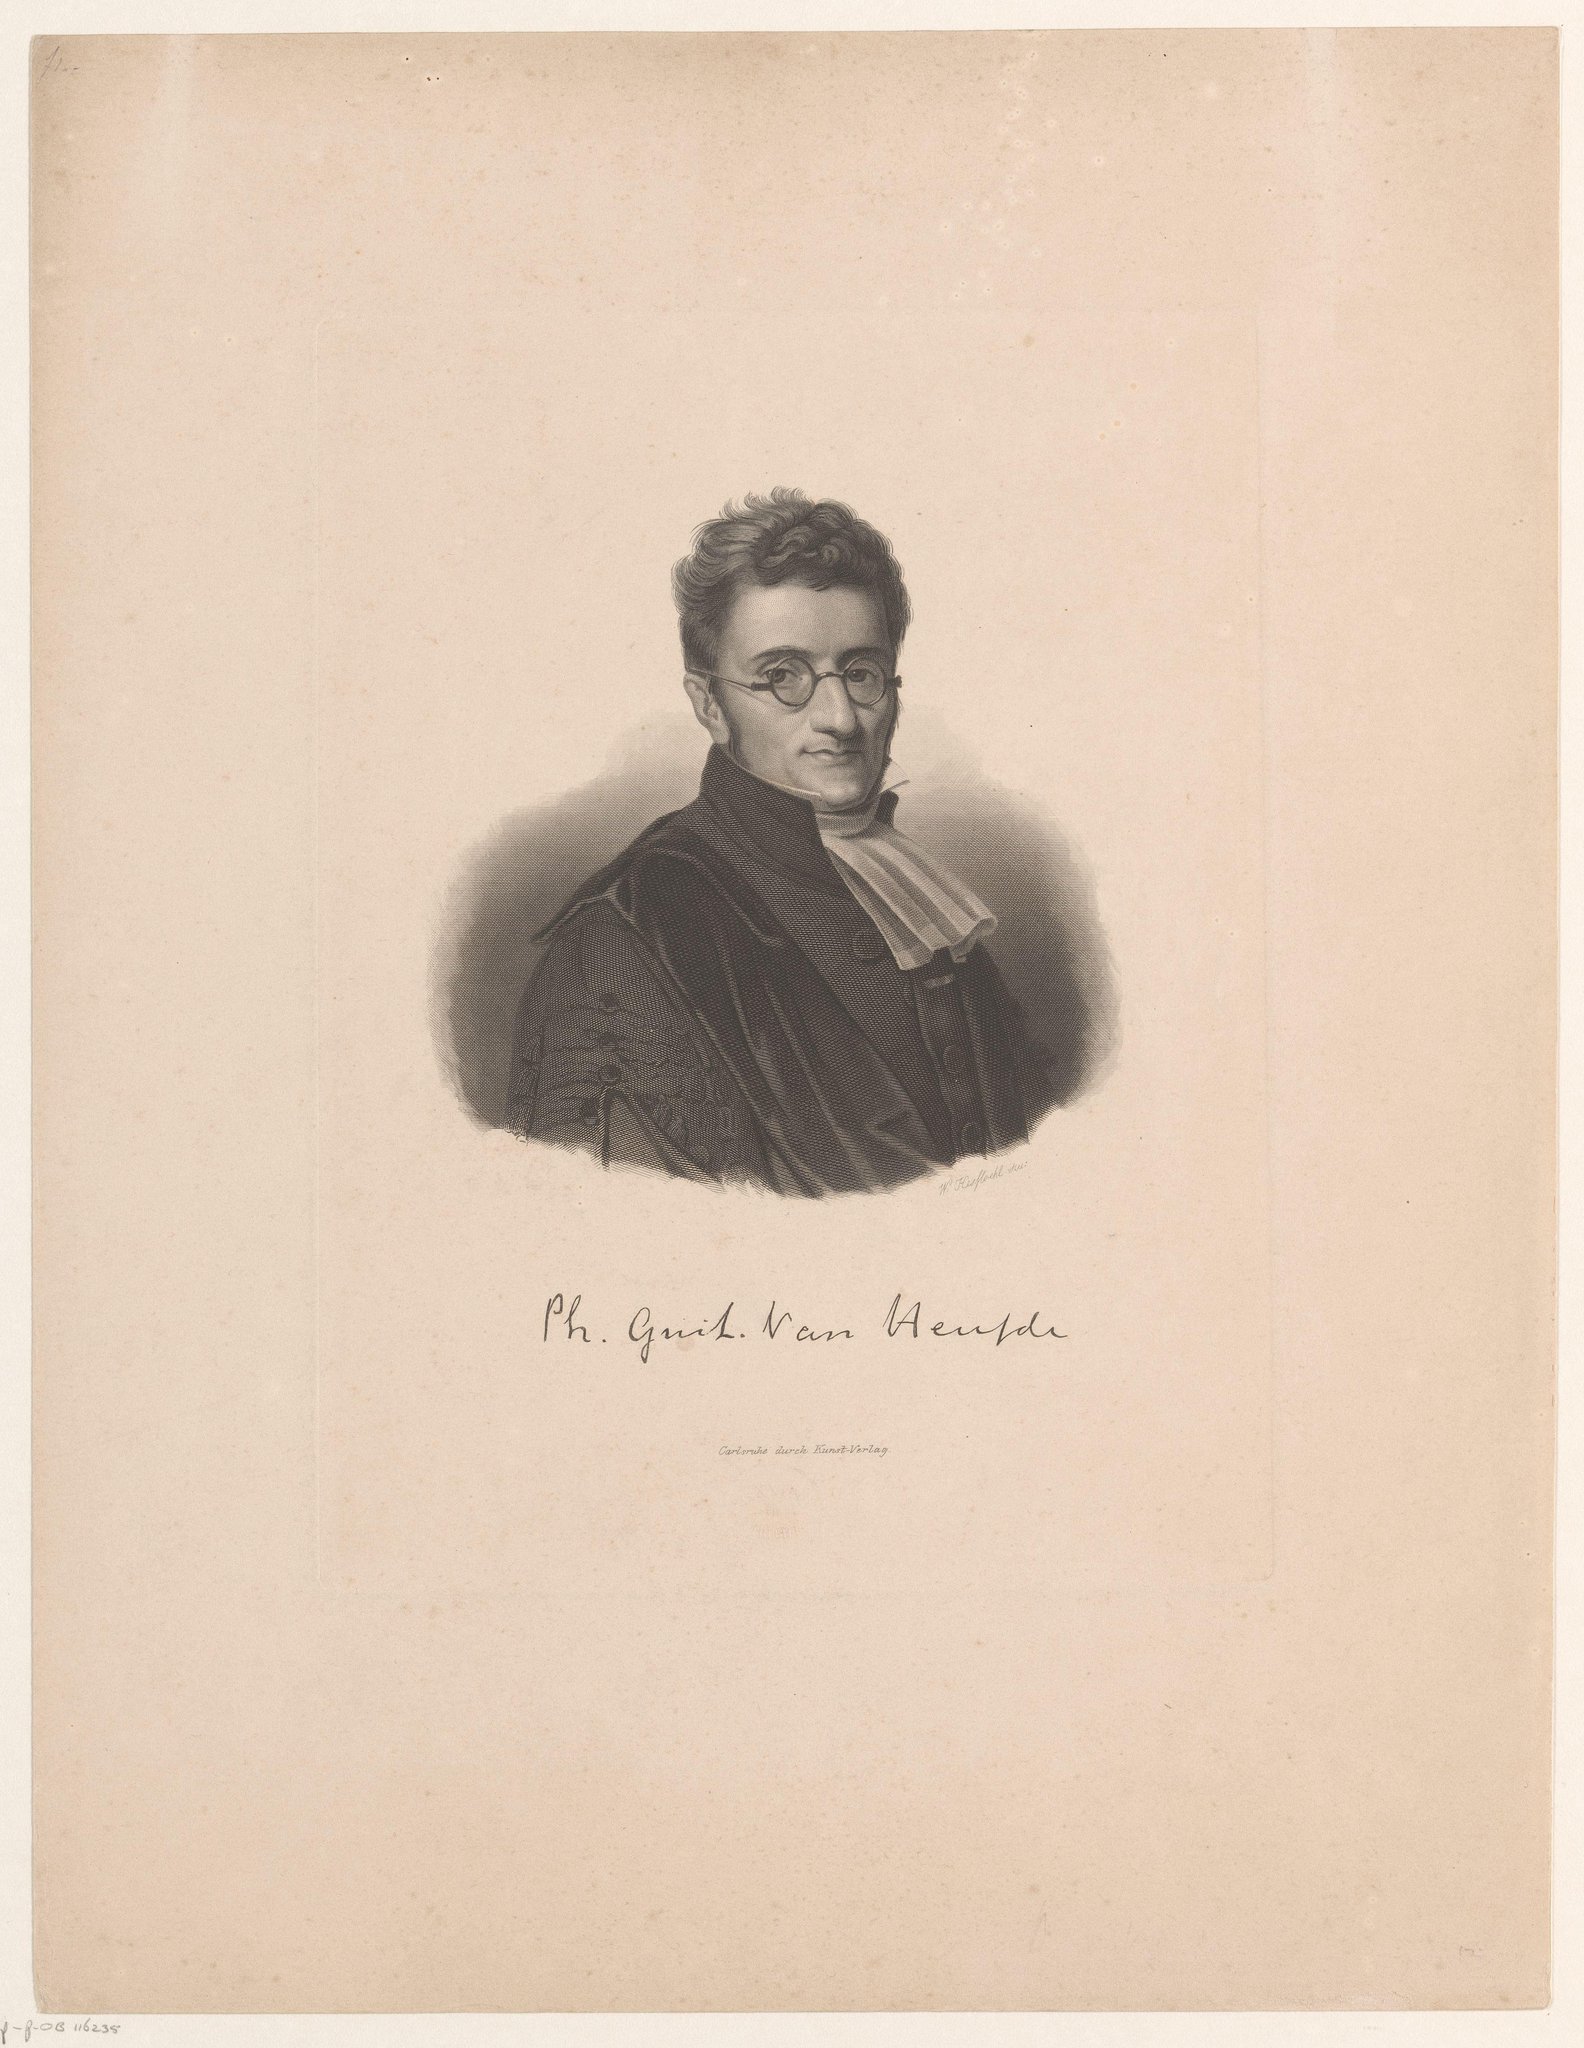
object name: print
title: Portret van Philip Willem van Heusde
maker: wilhelm hesslöhl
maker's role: print maker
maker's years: 1810-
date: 1820-1909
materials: paper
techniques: engraving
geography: karlsruhe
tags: rotterdam, historical persons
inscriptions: collector's mark: ‘R. Natan Utrecht’, collector's mark: Lugt 2228